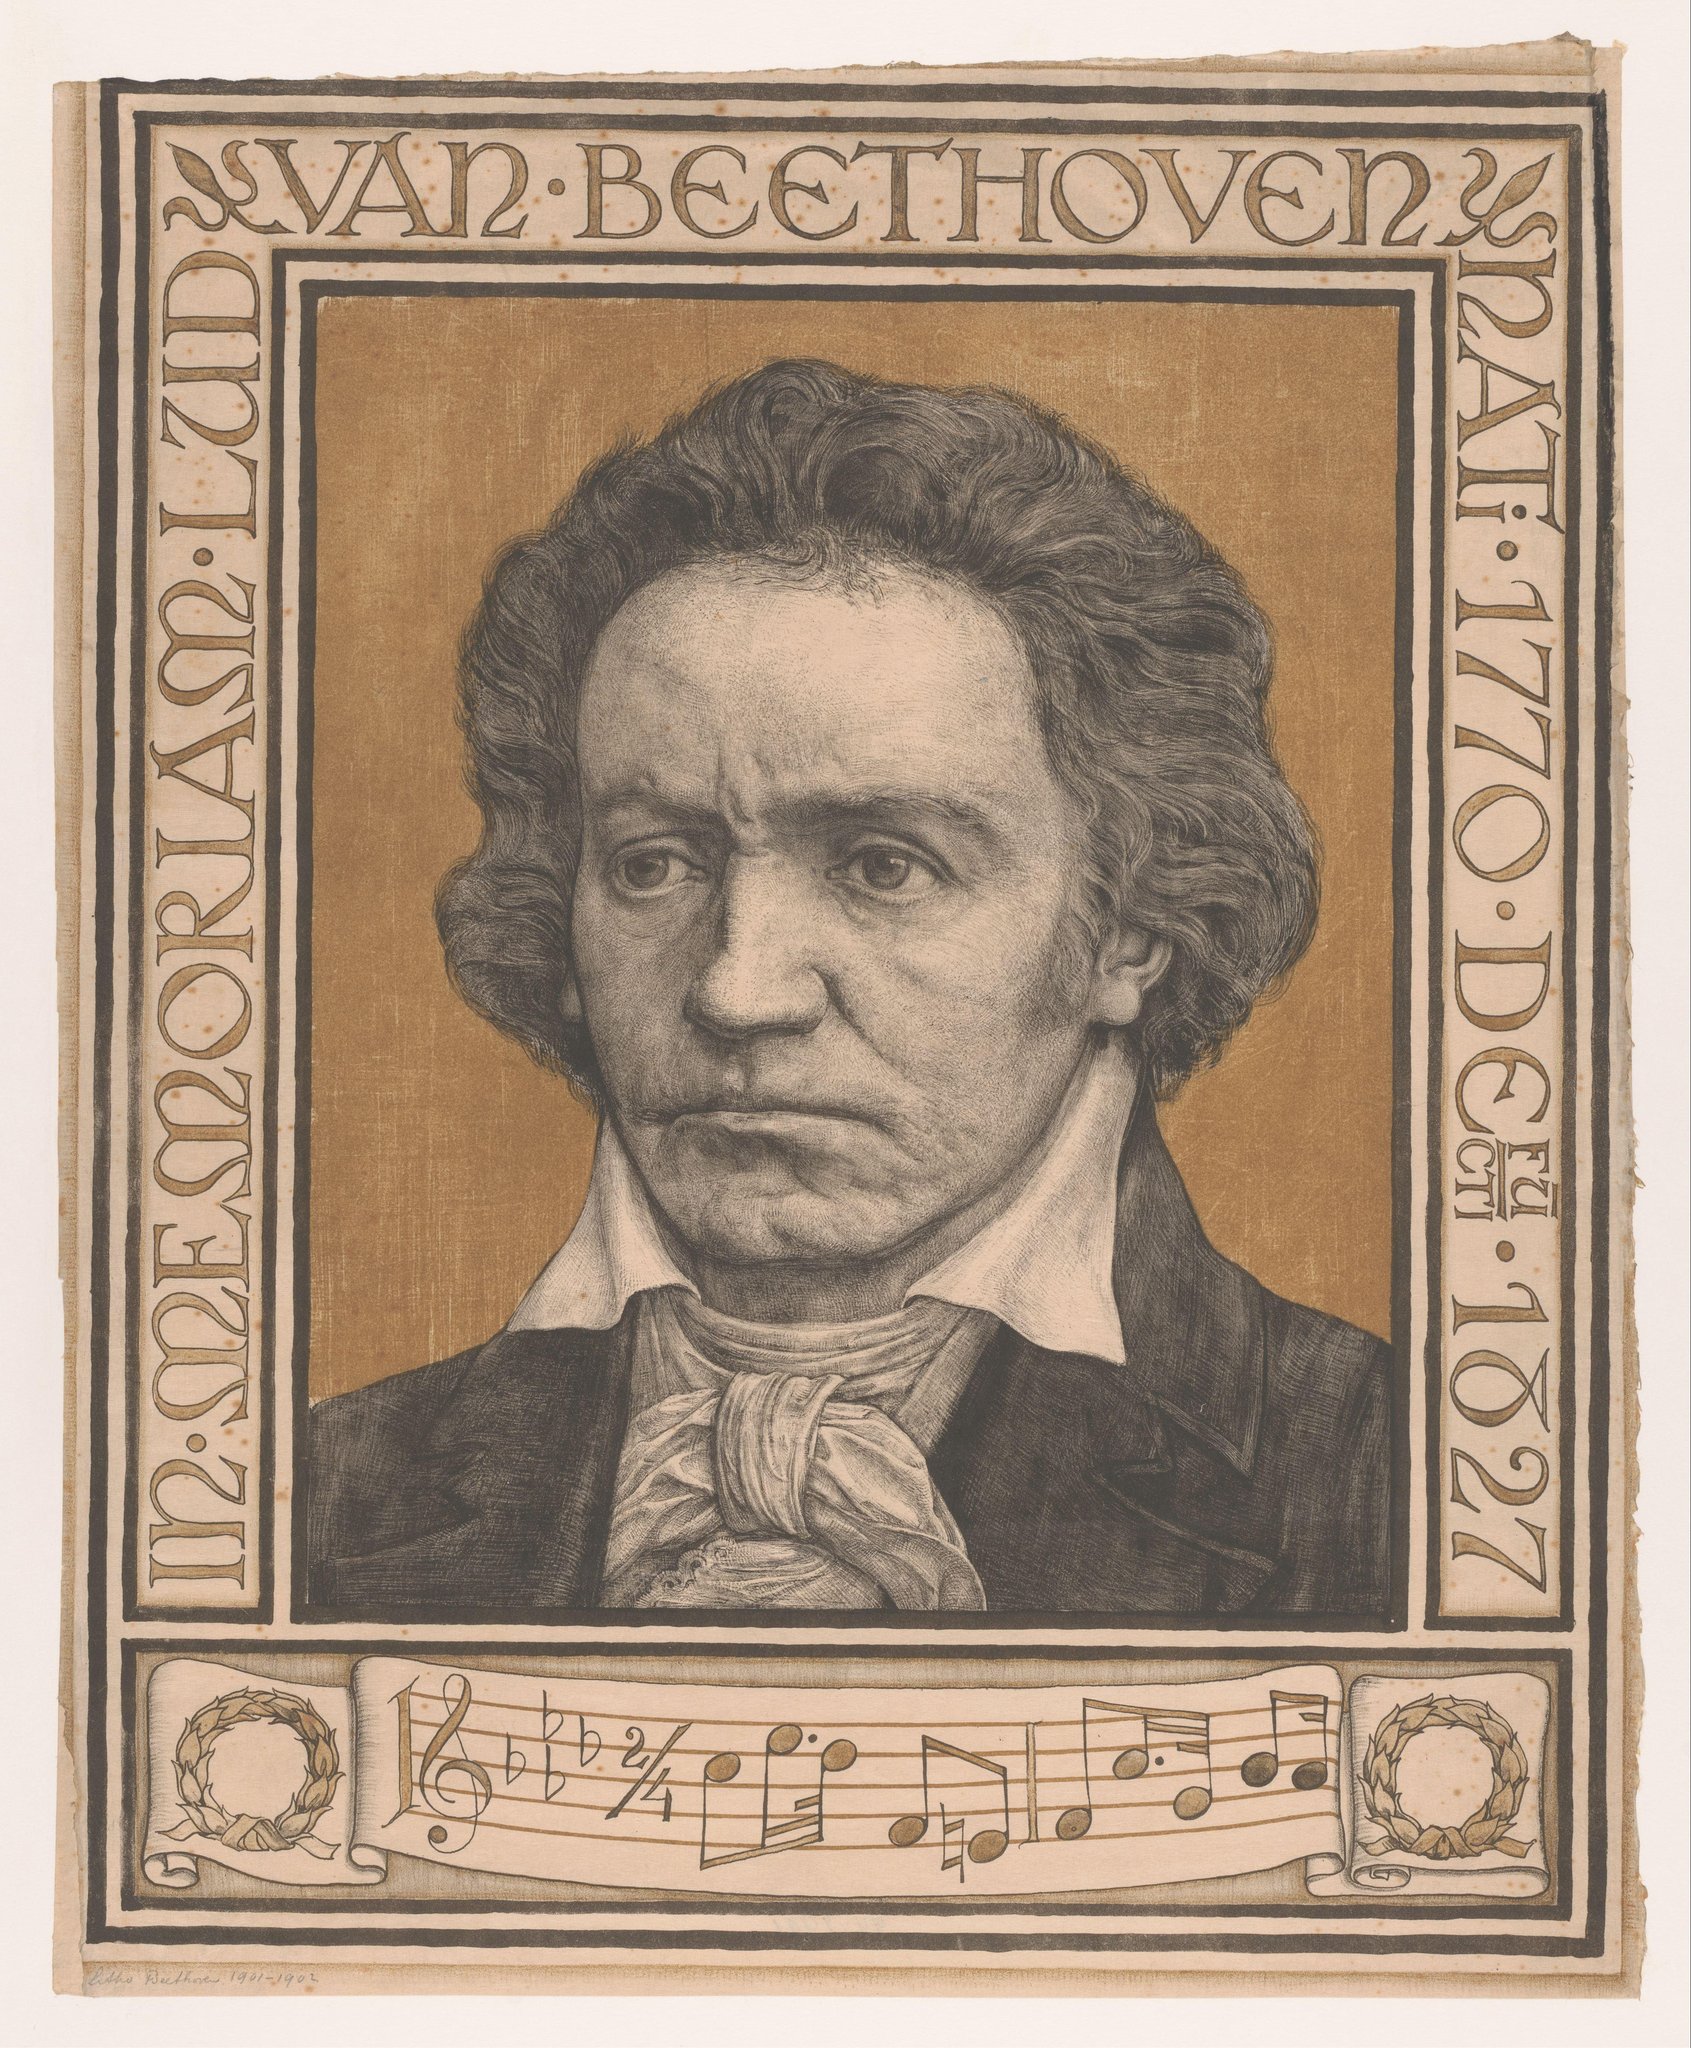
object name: print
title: Portret van Ludwig van Beethoven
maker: antoon derkinderen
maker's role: draughtsman, painter, print maker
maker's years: 1859-1925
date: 1901-1902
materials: paper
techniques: lithograph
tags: vienna, portrait of composer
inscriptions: collector's mark: Lugt 2228